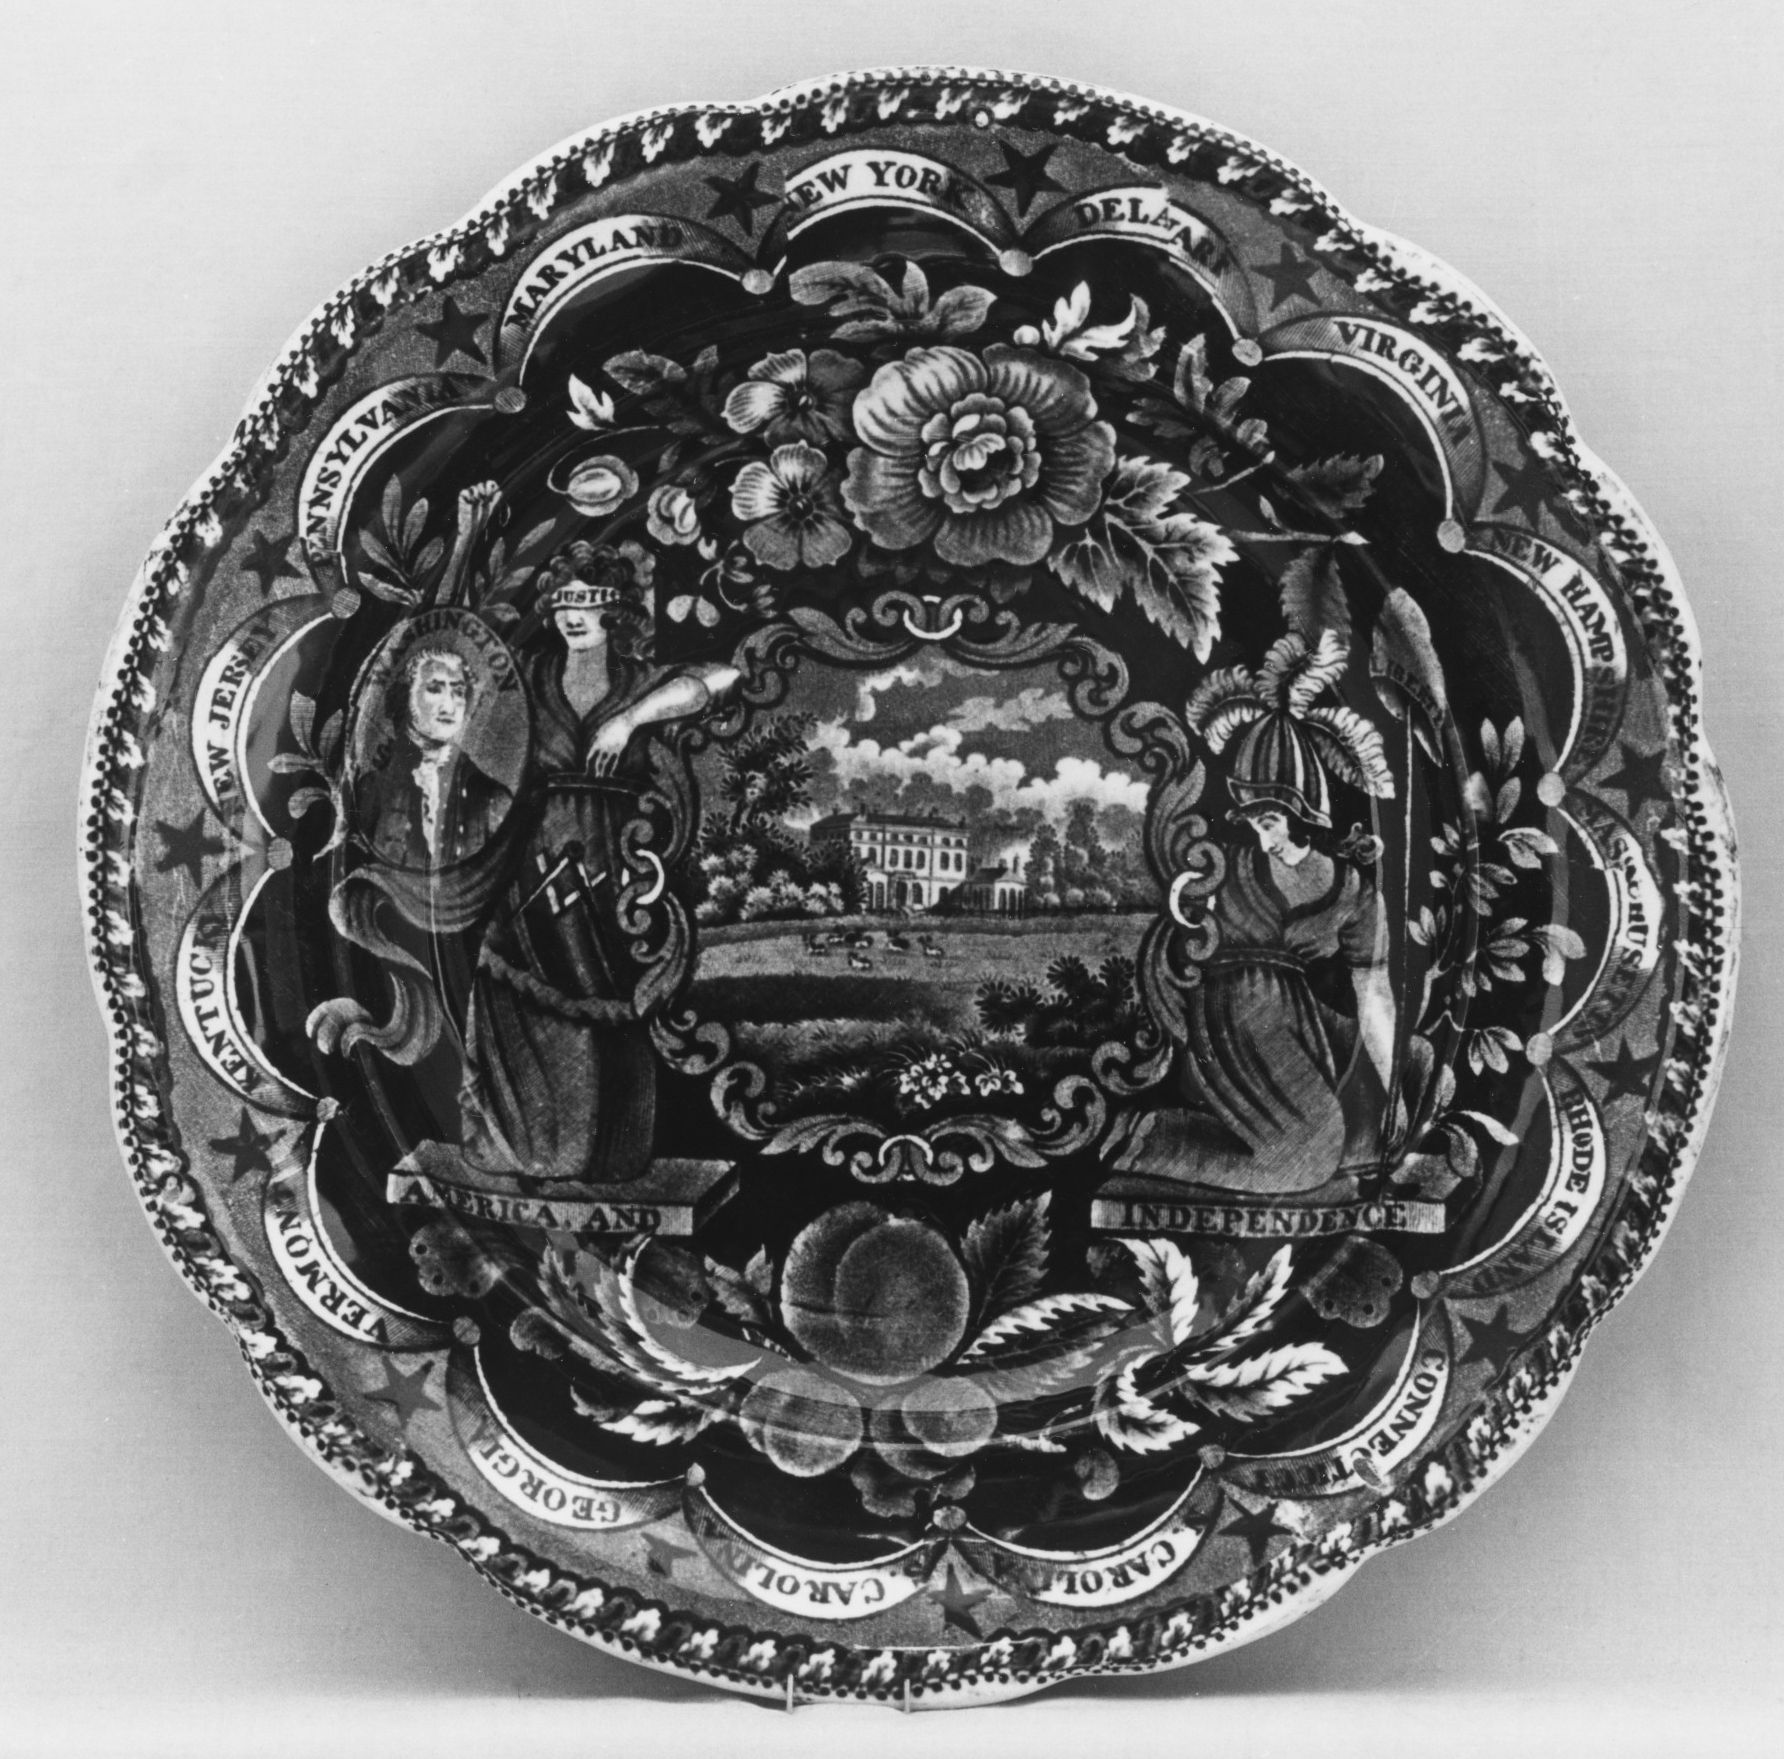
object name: plate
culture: british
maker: james and ralph clews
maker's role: maker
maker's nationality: british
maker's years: 1813-1836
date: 1815-1834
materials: earthenware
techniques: transfer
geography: england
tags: george washington,flowers